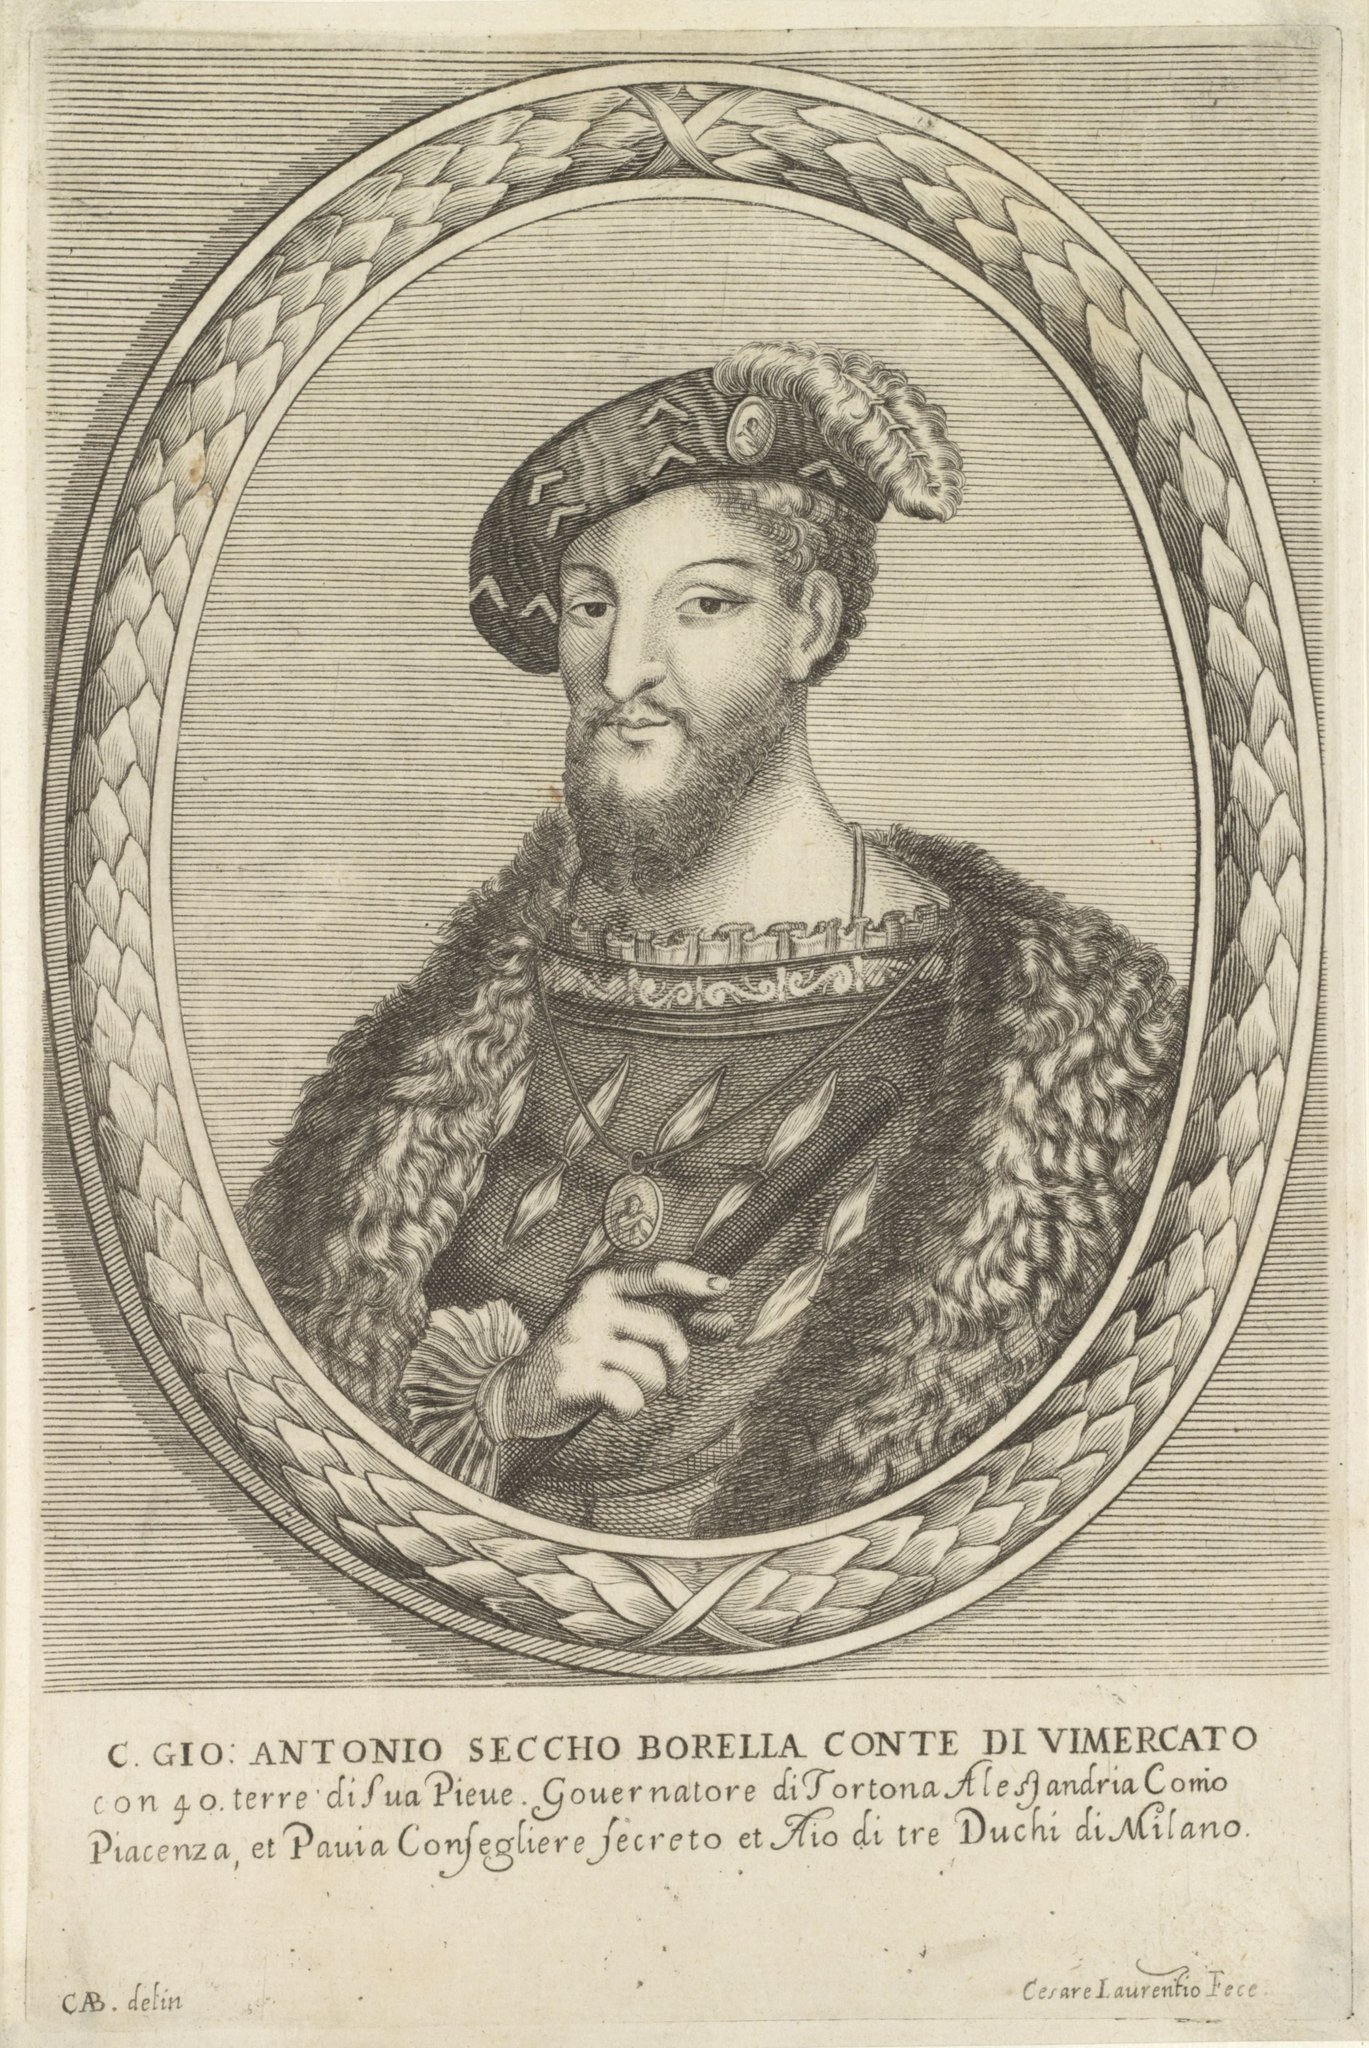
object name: print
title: portret van Giovanni Antonio Secco Borella, Conte Borella genoemd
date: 1600-1699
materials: paper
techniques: engraving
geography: italy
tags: politician, historical persons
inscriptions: collector's mark: Lugt 2228